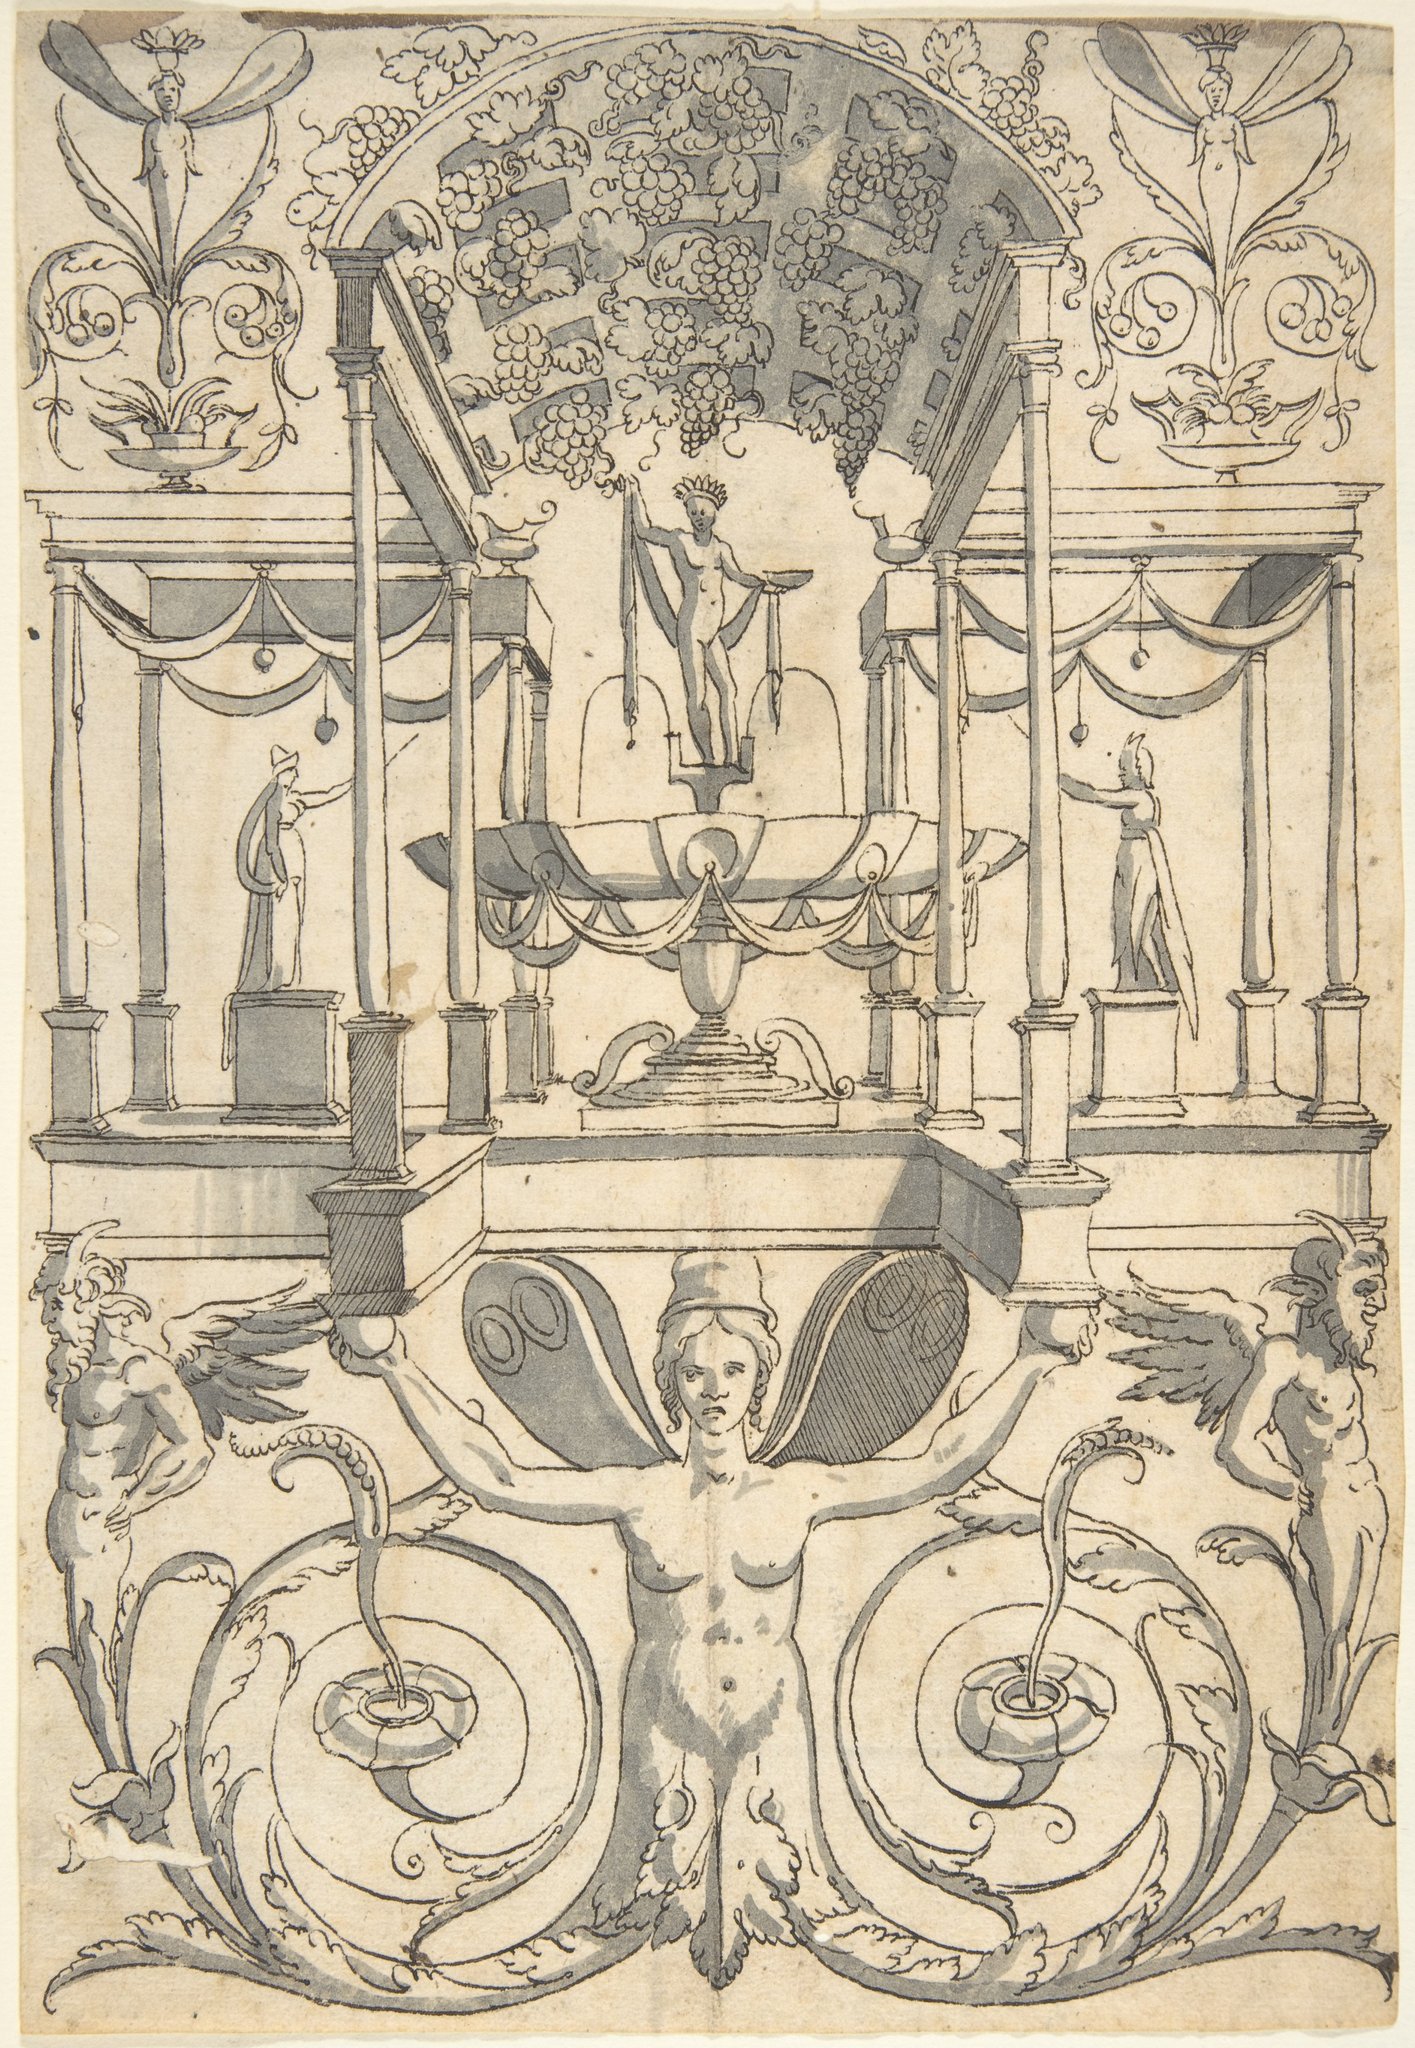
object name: ornament architecture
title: Grotesque with a Bacchus Fountain Placed in an Architectural Structure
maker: anonymous, italian, 16th century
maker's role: artist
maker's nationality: italian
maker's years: 1500-1600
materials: ink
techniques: brush, pen, wash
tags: fountains,grotesques,ornament,mythical creatures